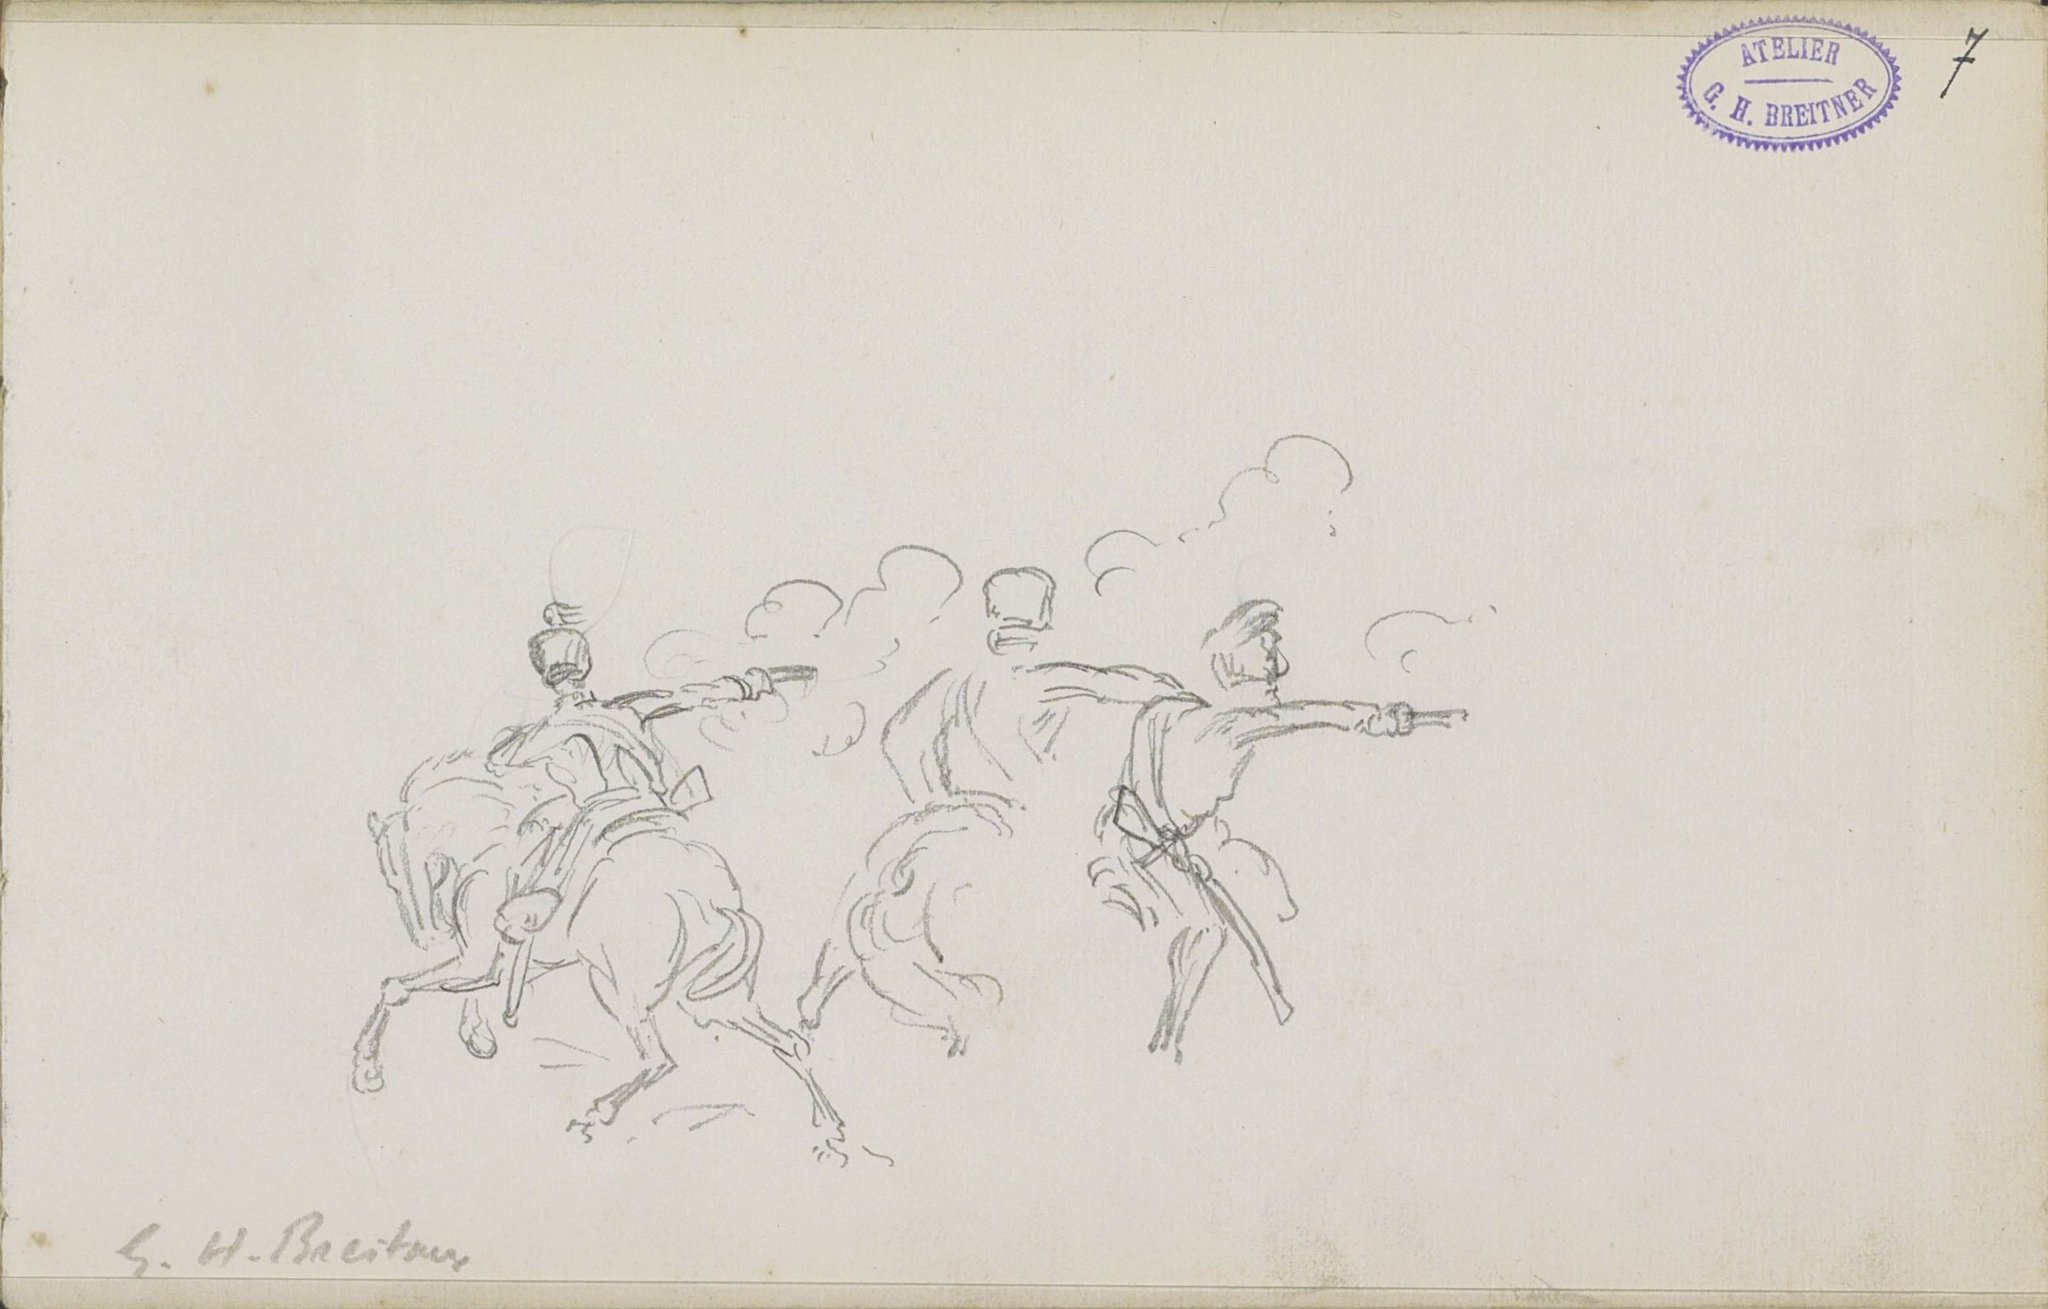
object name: sketchbook leaf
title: Drie soldaten te paard met getrokken pistool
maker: george hendrik breitner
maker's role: draughtsman, painter, print maker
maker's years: 1857-1923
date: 1874-1876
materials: paper, pencil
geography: rotterdam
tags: division of armed forces (+ during the battle), division of armed forces (+ cavalry, horsemen), firearms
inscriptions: signature: ‘G.H. Breitner’, workshop stamp: Lugt 291d